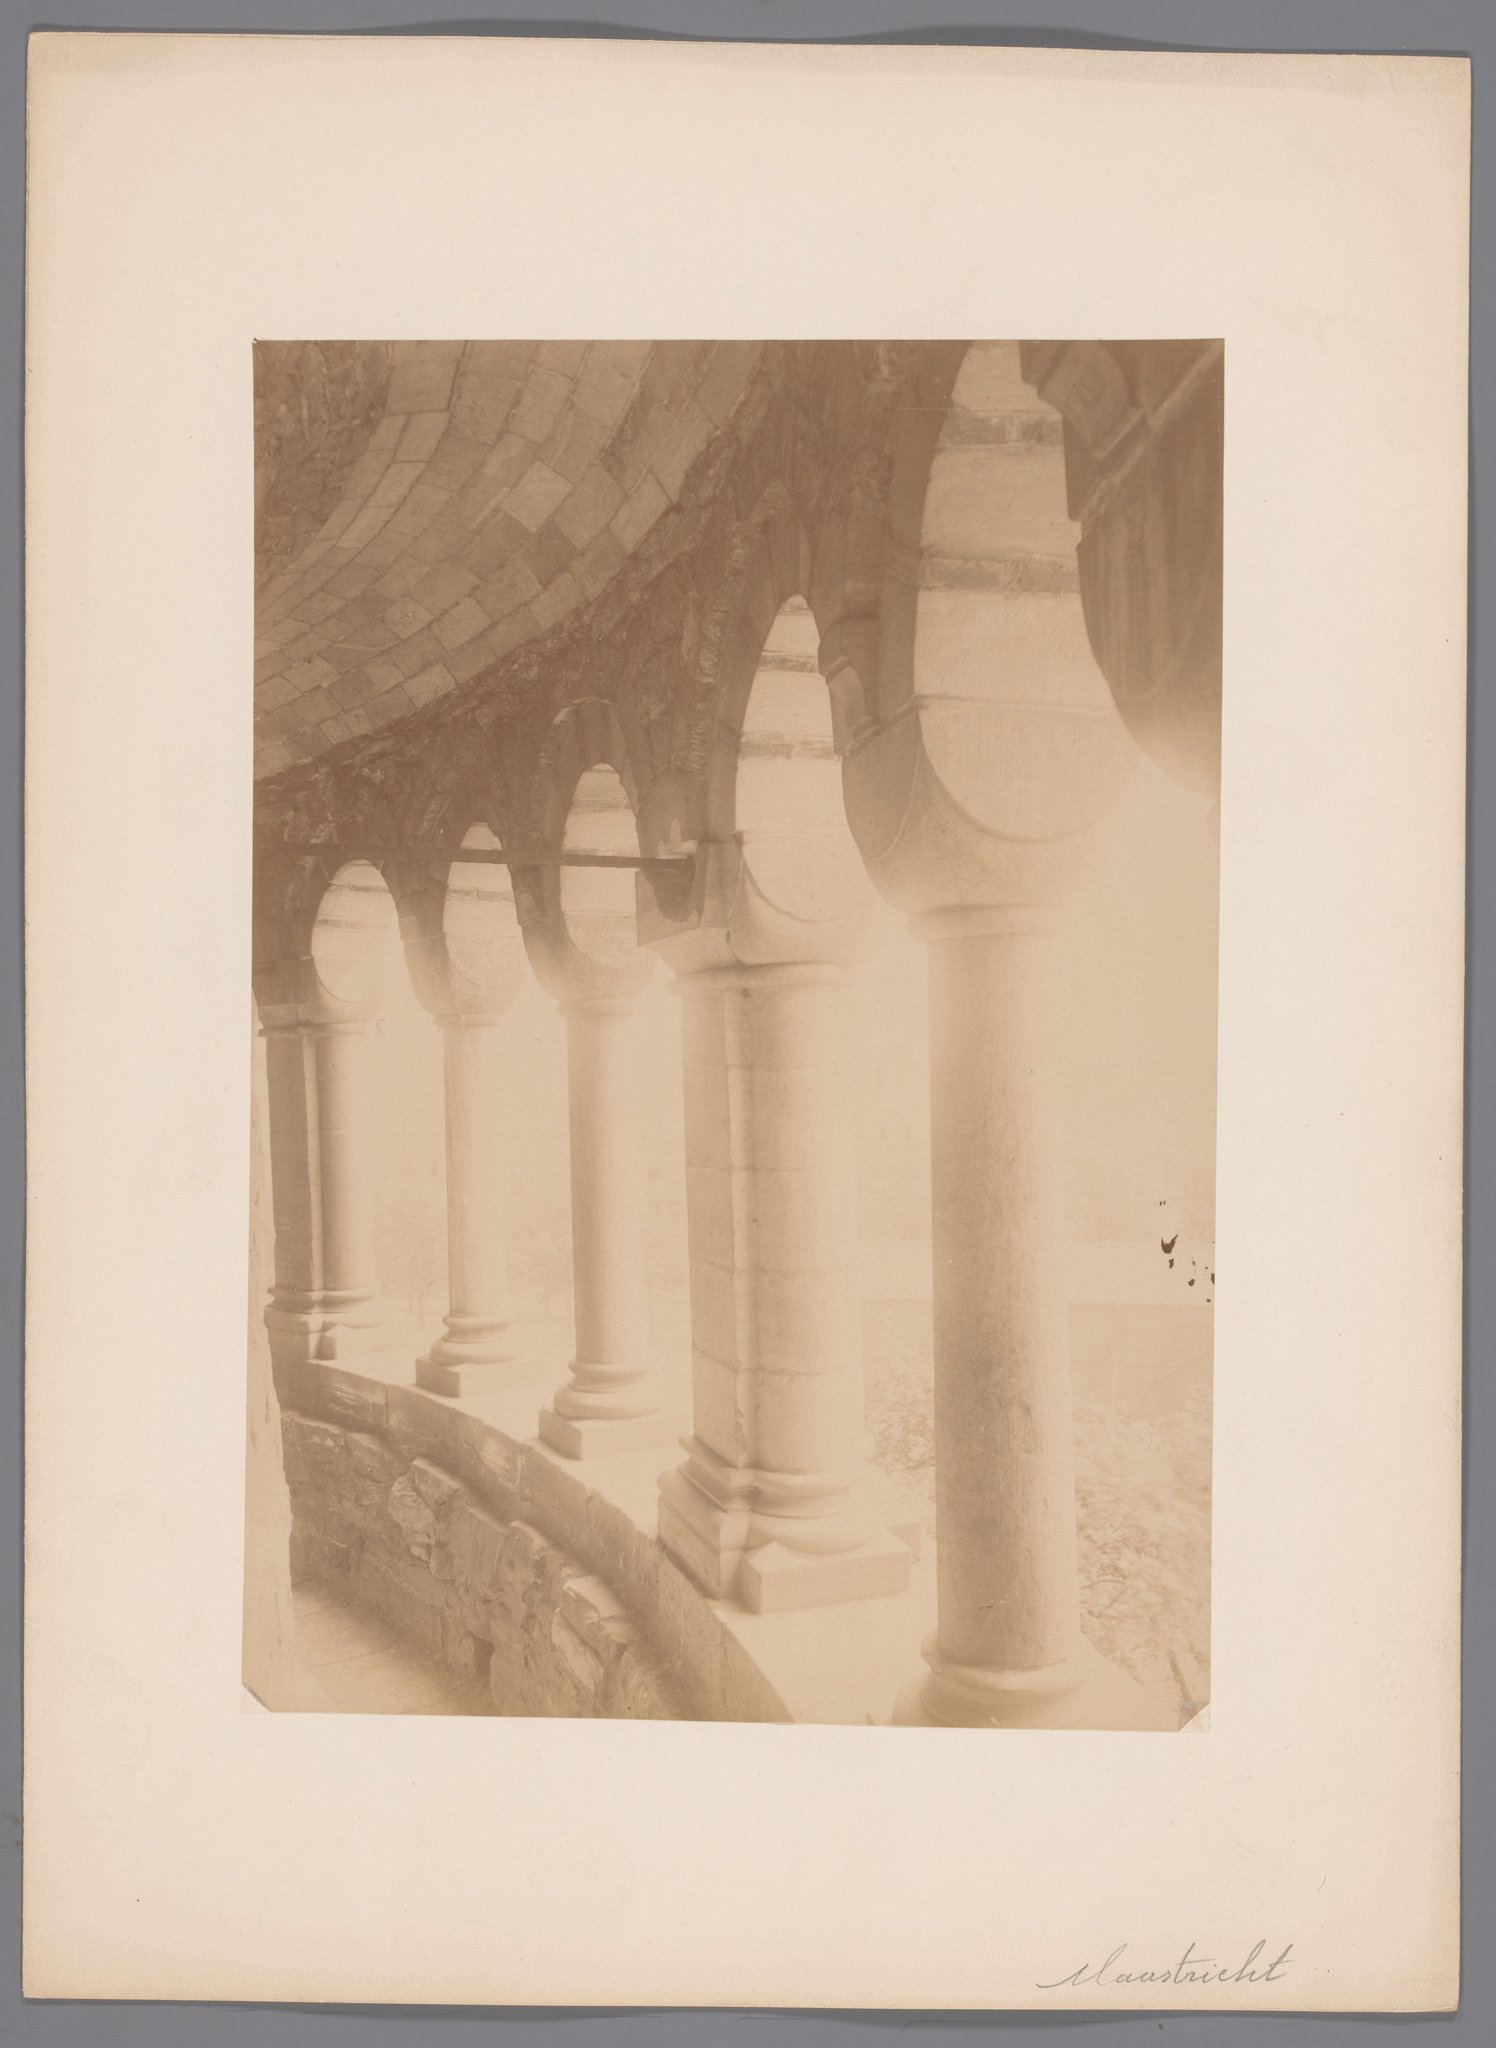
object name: photograph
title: Gezicht op het triforium van het koor van de Sint-Servaasbasiliek te Maastricht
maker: anoniem (monumentenzorg)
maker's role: fotograaf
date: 1893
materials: cardboard, photographic support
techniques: albumen print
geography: maastricht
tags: column, pillar ~ architecture, interior of church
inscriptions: annotation: ‘Maastricht’, annotation: ‘St. Servaaskerk Maastricht/ gezicht in de uitwendige triforiums van het koor/ Mei 1893’